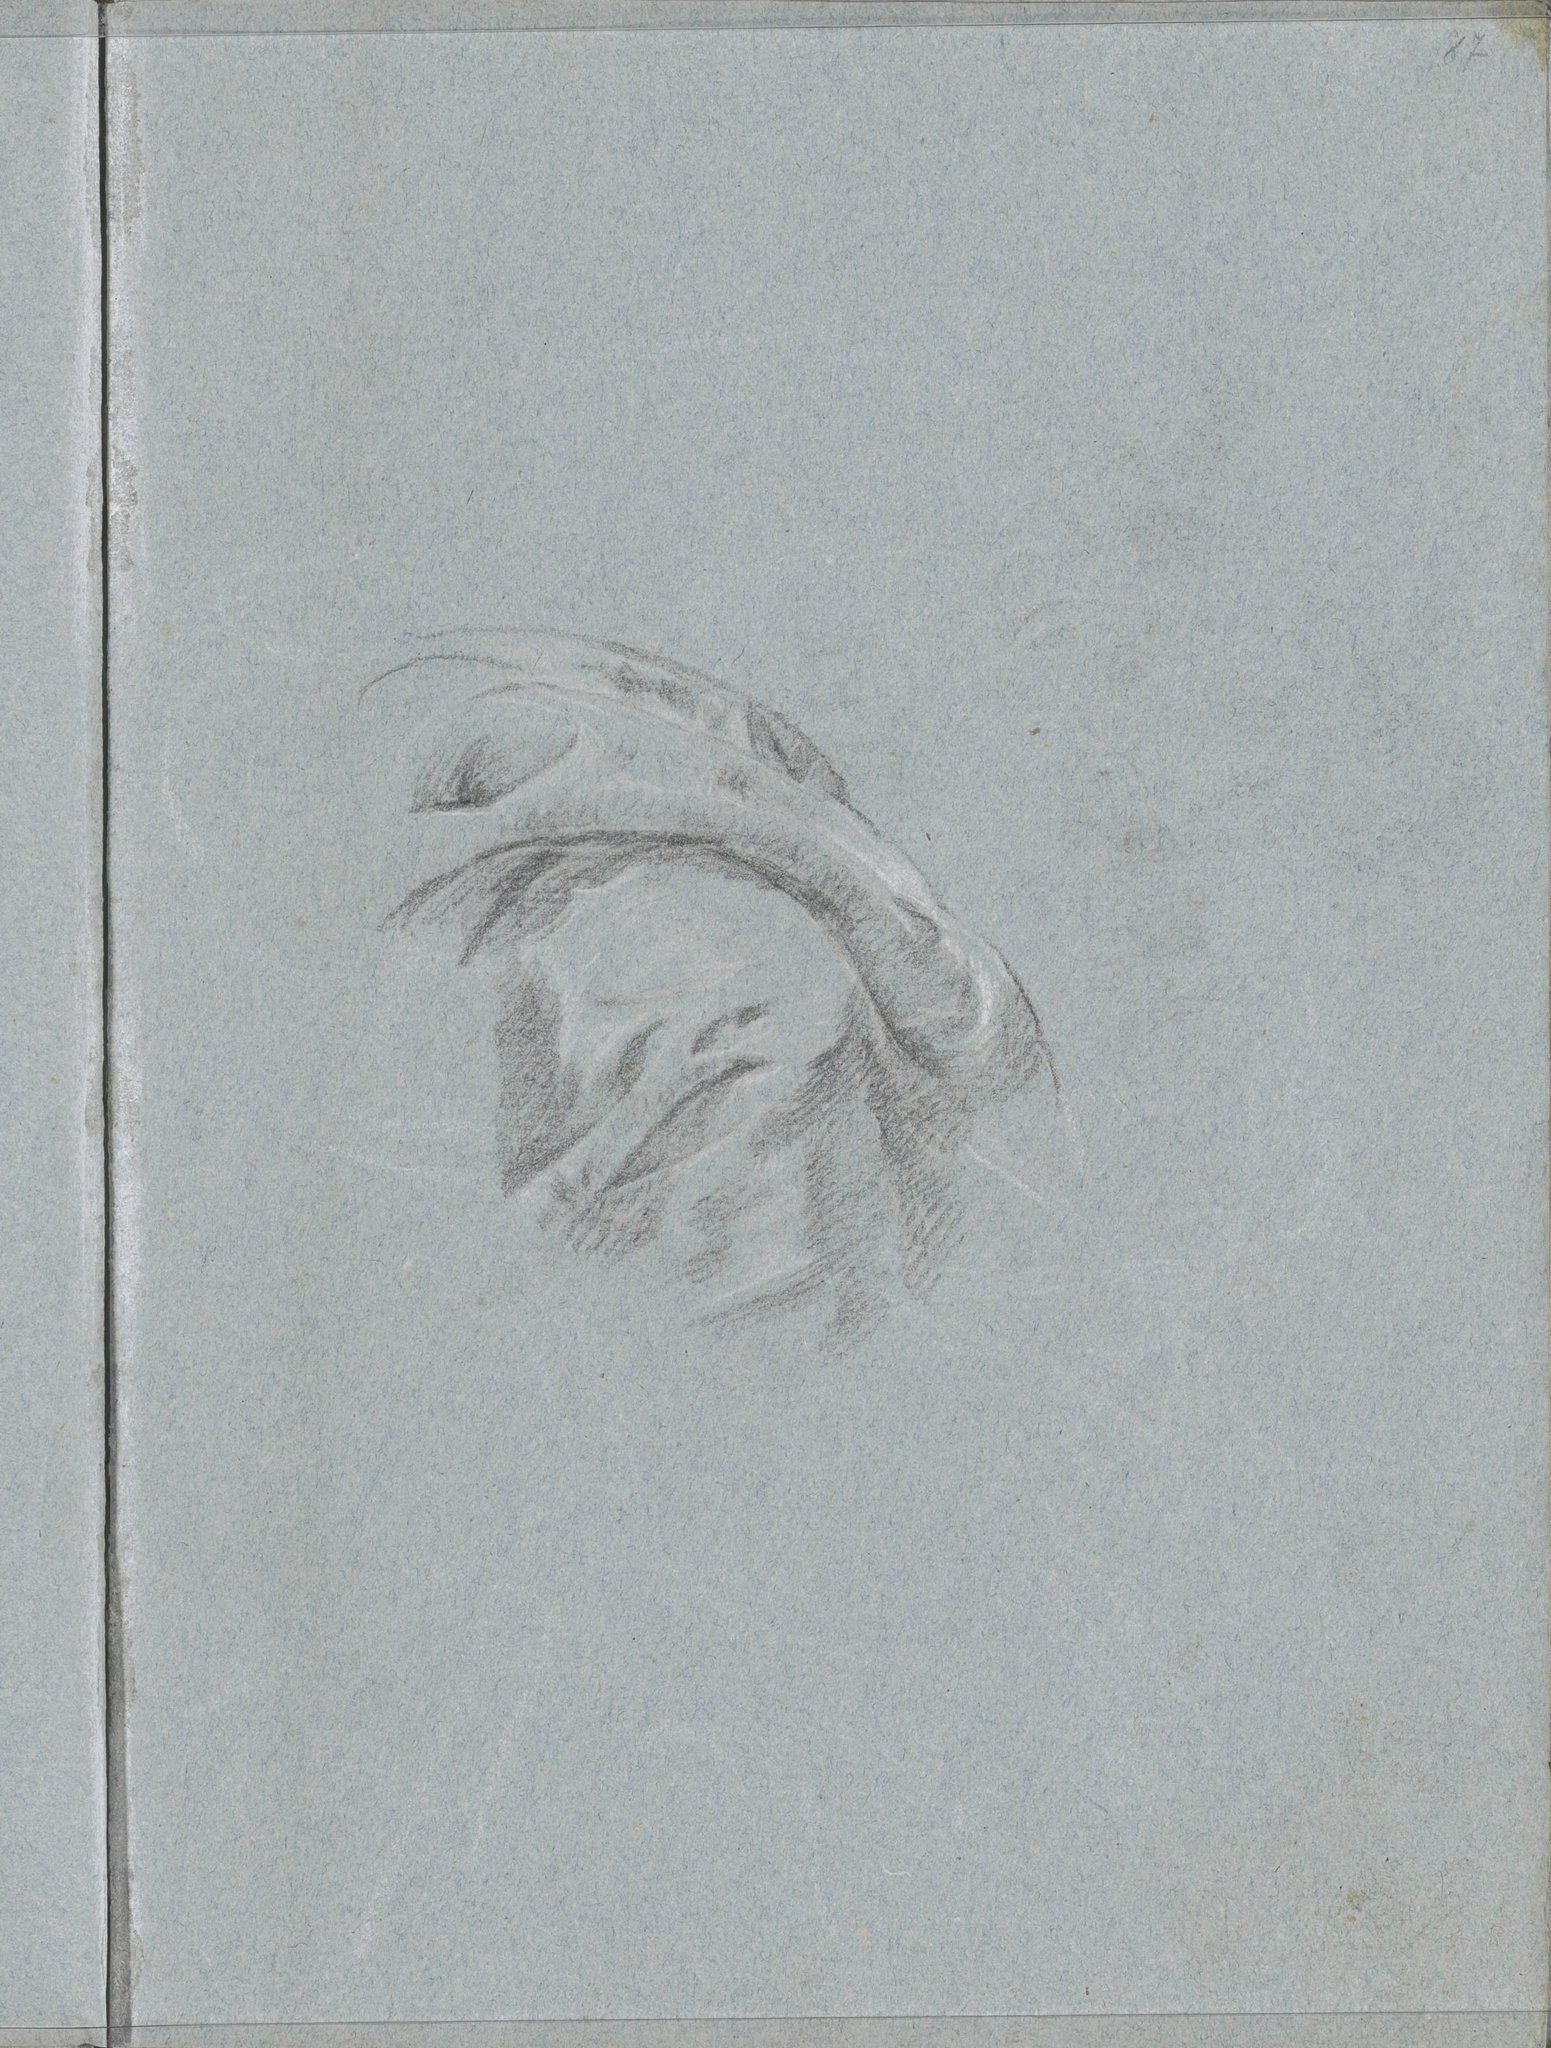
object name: sketchbook leaf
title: Draperie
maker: lorenzo baldissera tiepolo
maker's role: draughtsman, print maker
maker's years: 1736-1776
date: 1751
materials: chalk, paper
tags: drapery, draped garment, 'gewandgebung'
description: Bladzijde 87 uit een schetsboek met 158 bladzijden.